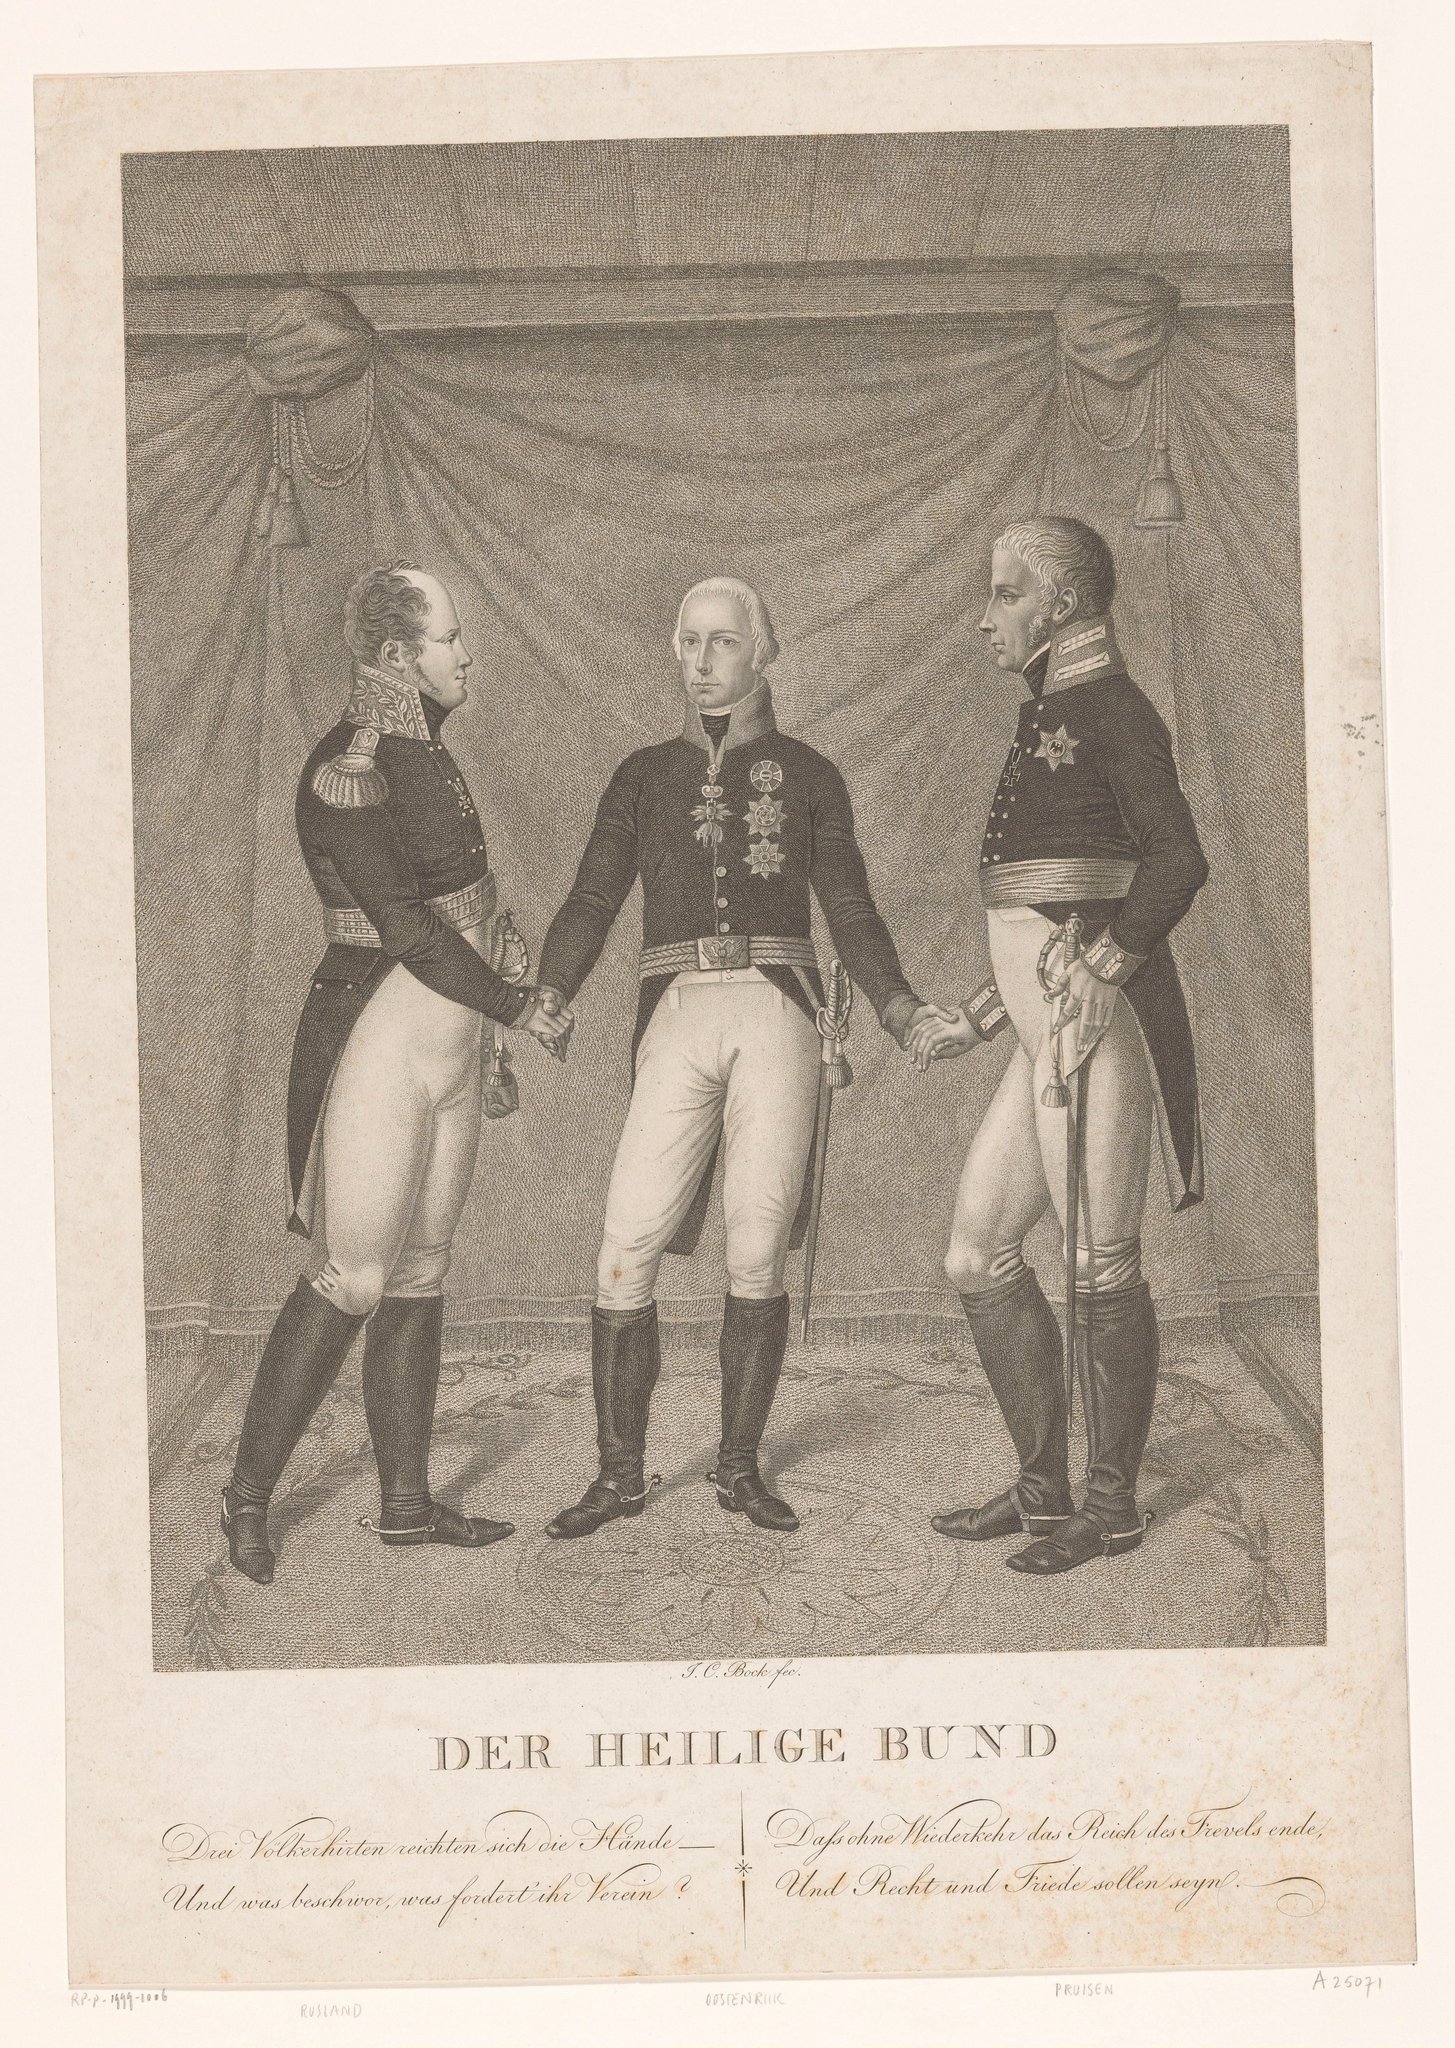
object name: print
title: Heilige Alliantie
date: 1815-1818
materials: paper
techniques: etching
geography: nuremberg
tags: vienna, frans ii (rooms-duits keizer), alexander i (tsaar van rusland), frederik willem iii koning van pruisen, peace negotiations, knighthood order (with name) - insignia of a knighthood order, e.g.: badge, chain (with name of order), historical persons, knighthood order of the golden fleece - insignia of a knighthood order, e.g.: badge, chain (with name of order)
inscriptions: collector's mark: Lugt 2760, collector's mark: Lugt 2228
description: De heersers van Rusland, Oostenrijk en Pruisen reiken elkaar de hand als teken van het de Heilige Verbond of de Heilige Alliantie, afgesloten in Parijs op 26 september 1815. Links tsaar Alexander I van Rusland, in het midden keizer Frans I van Oostenrijk en rechts koning Frederik Willem III van Pruisen.